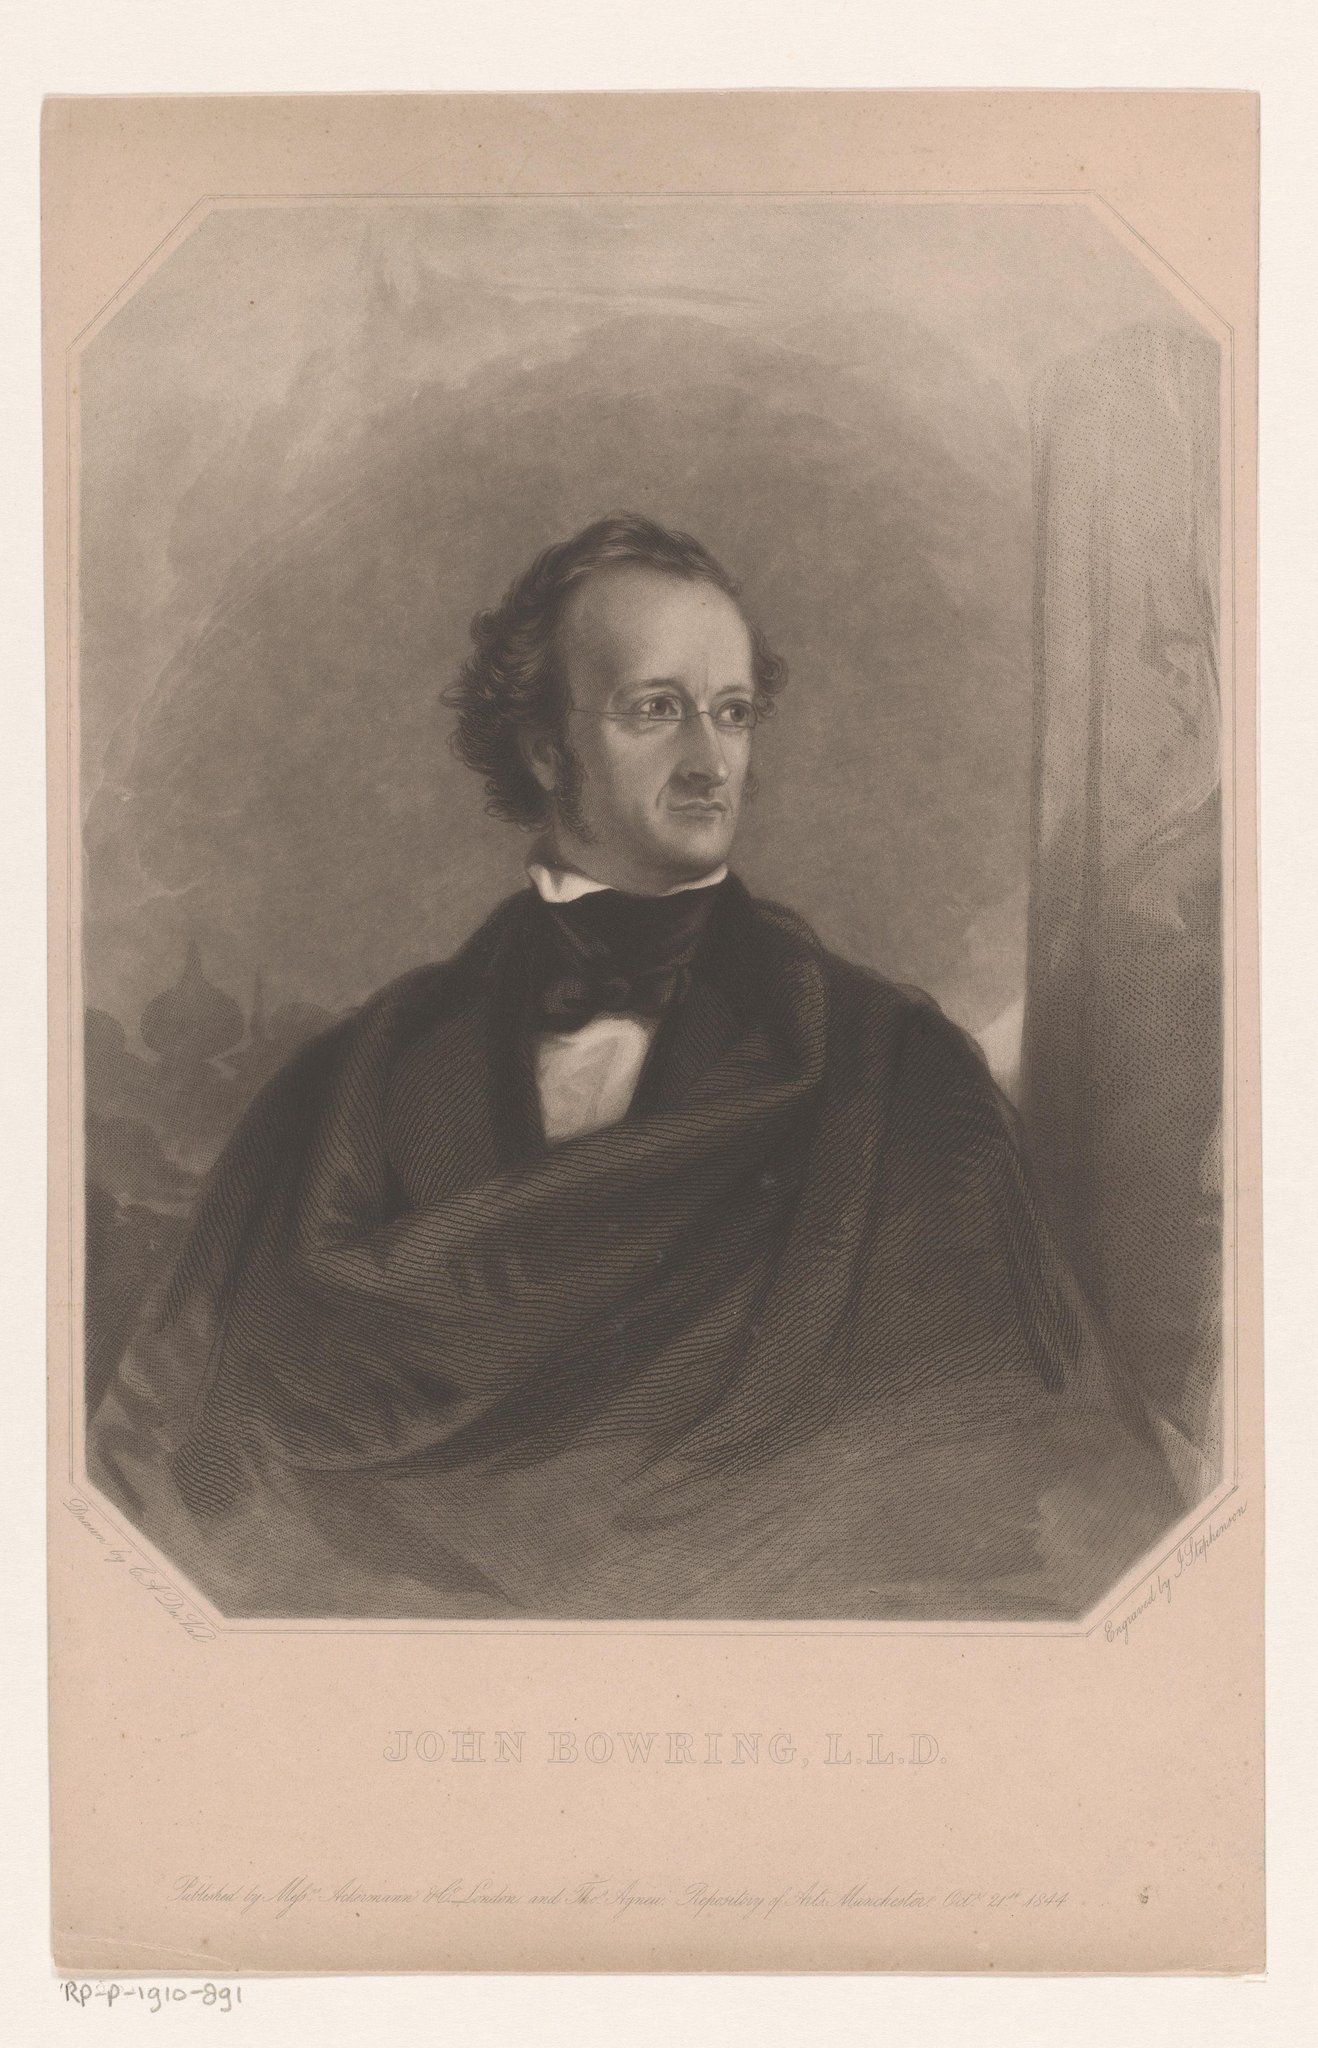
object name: print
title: John Bowring, L.L.D.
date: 1810-1844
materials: paper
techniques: etching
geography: london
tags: historical persons, politician, e.g. party leader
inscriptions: collector's mark: Lugt 2228